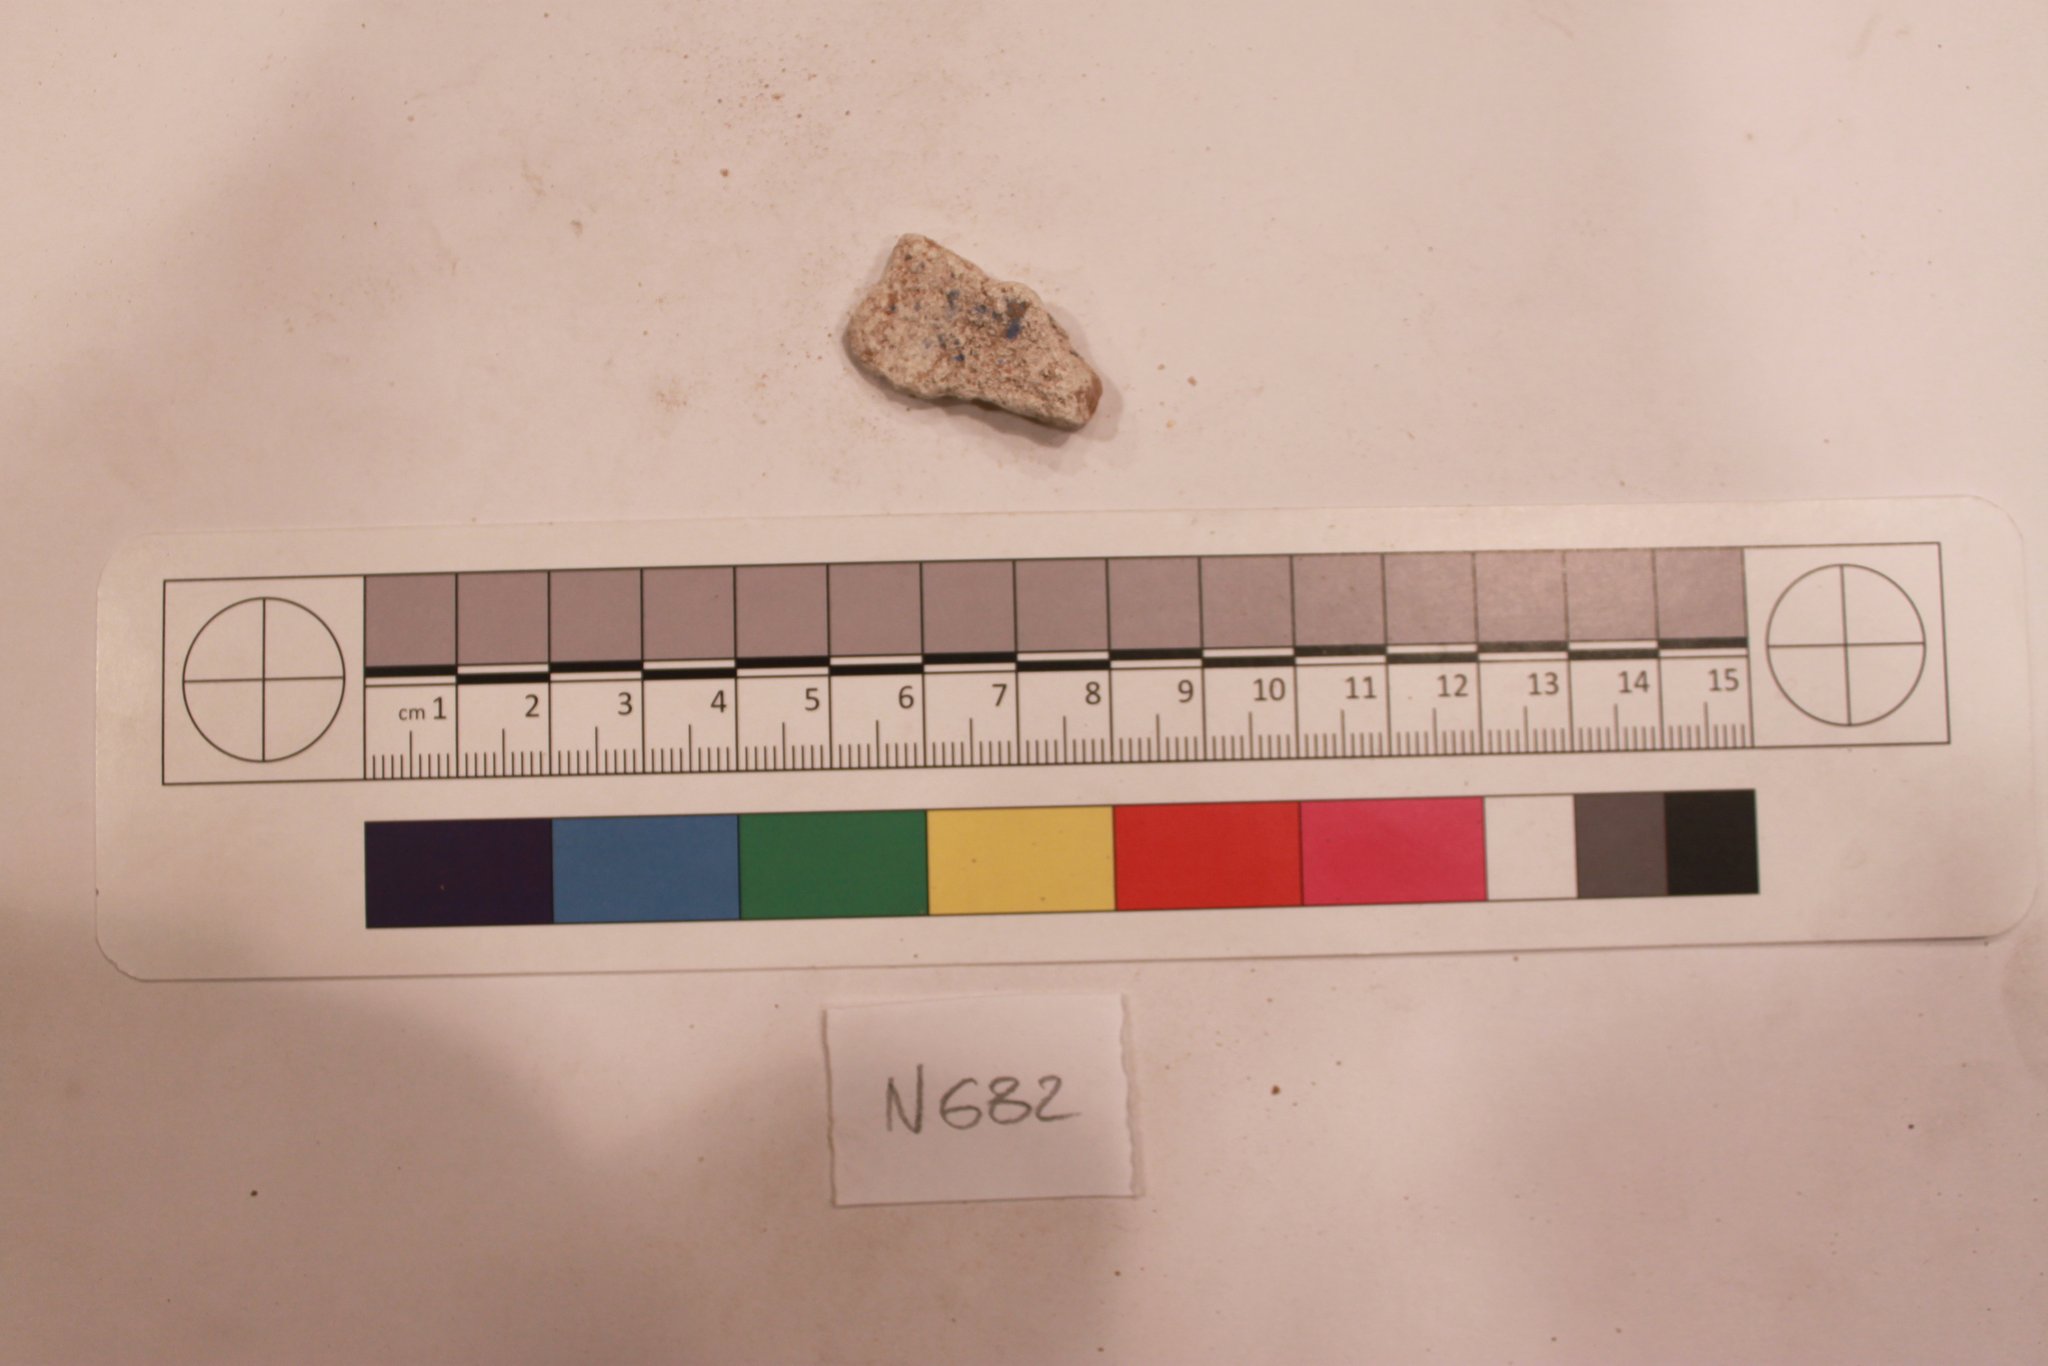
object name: fragment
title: Stucco Fragment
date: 701-1200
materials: plaster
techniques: carving, painting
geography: iran